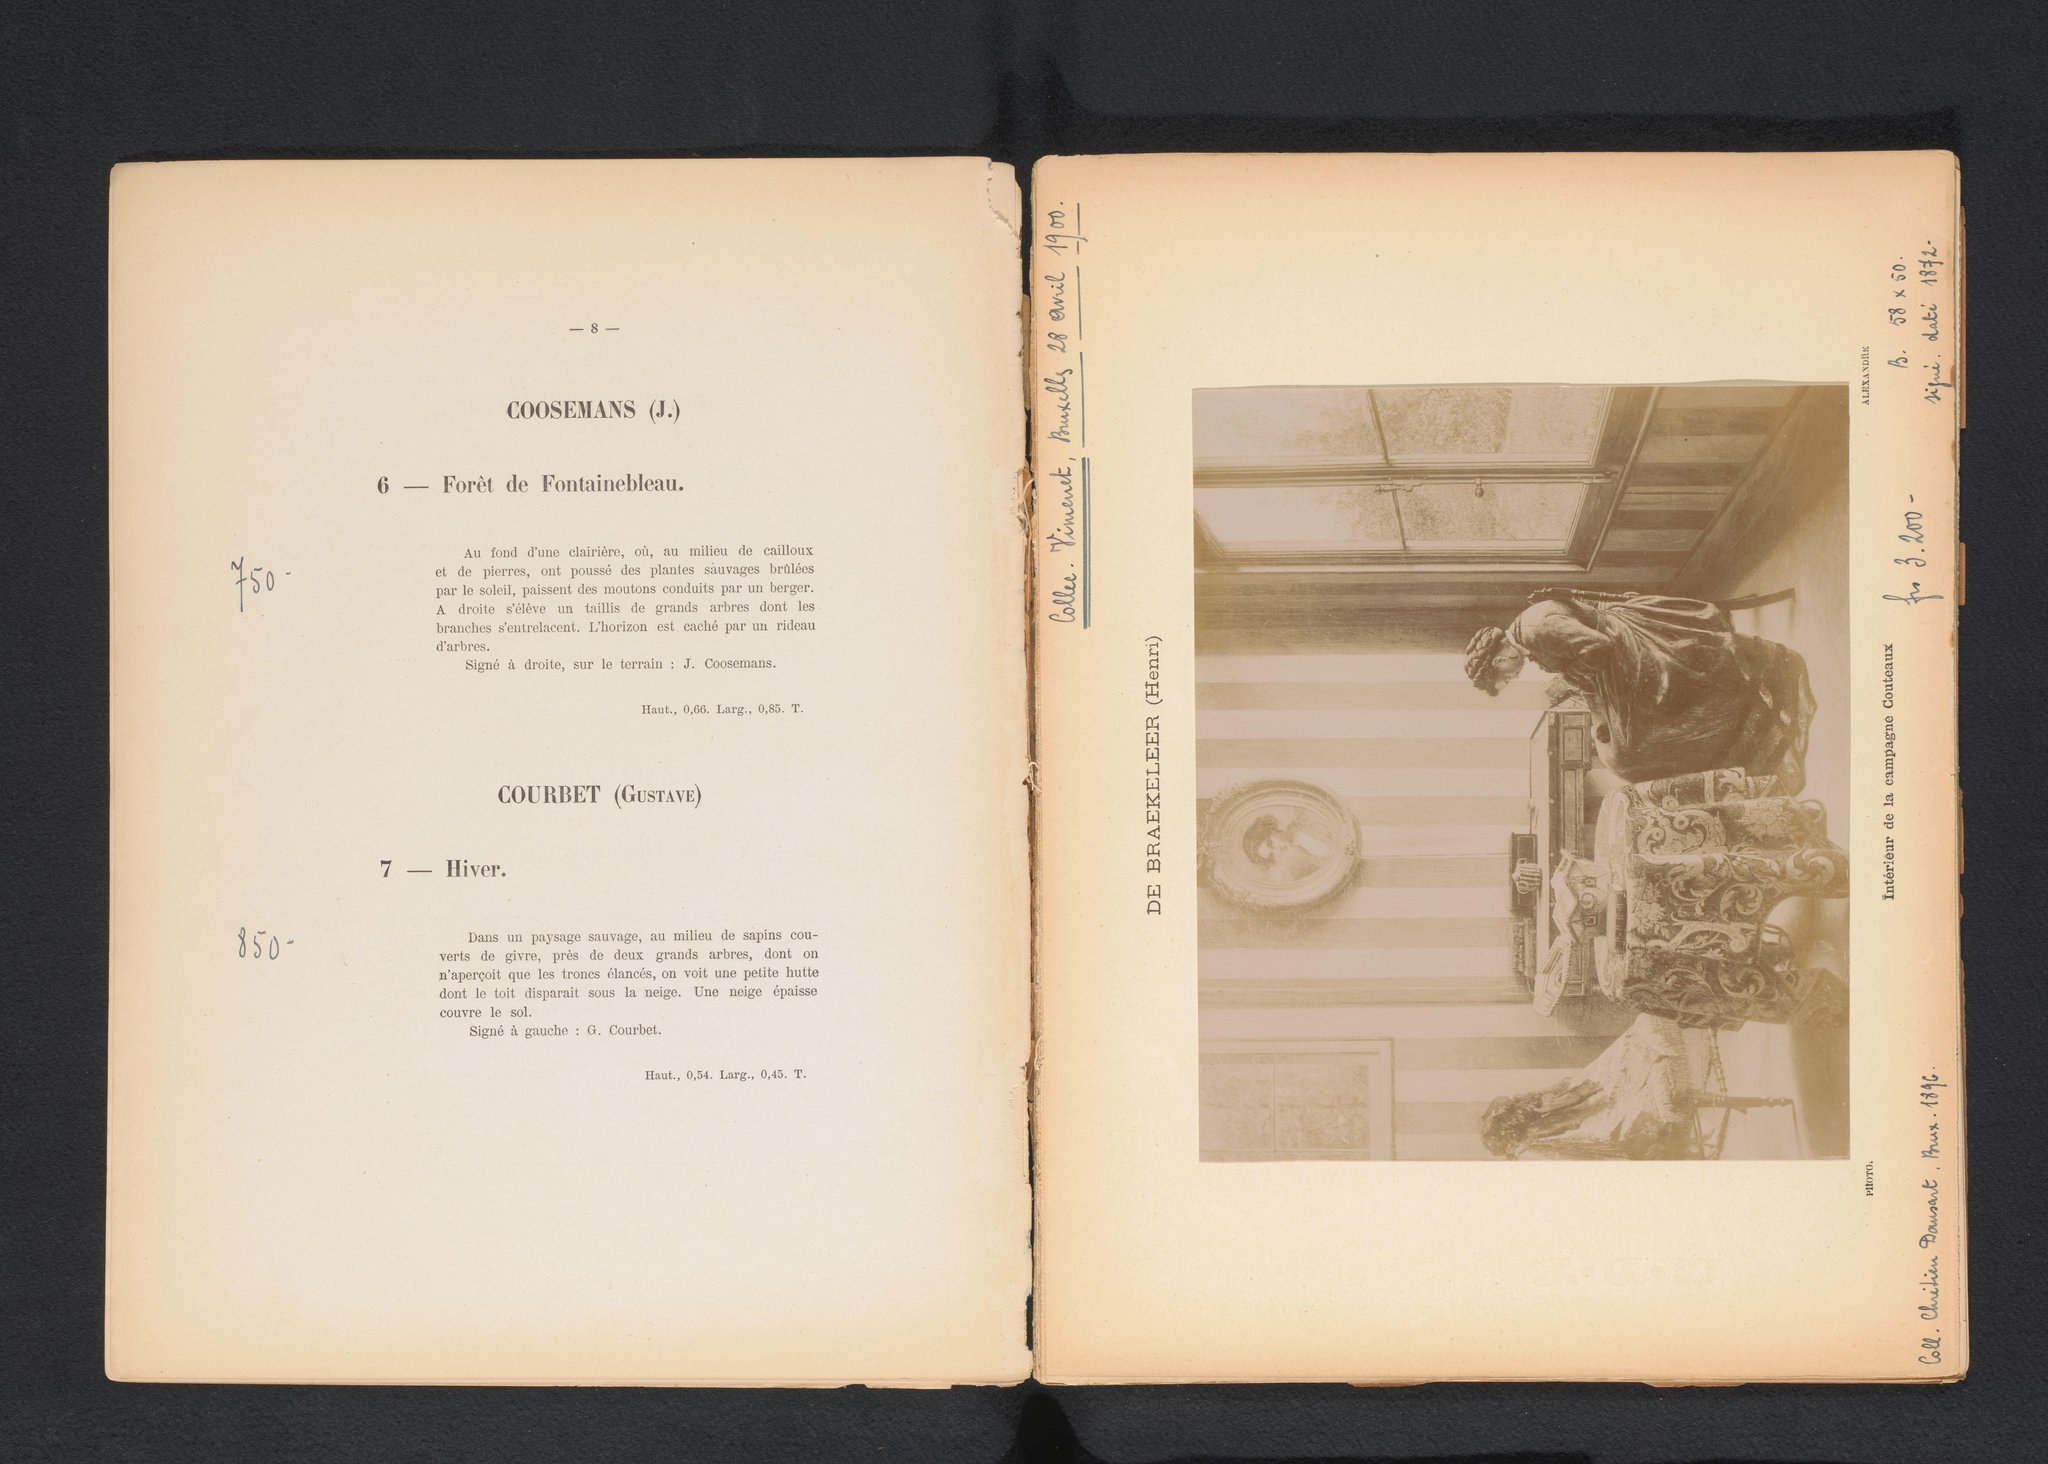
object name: photograph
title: Intérieur de la campagne Couteaux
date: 1895-1900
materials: photographic support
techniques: gelatin silver print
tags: adult woman, (other forms of) needlework, e.g.: crocheting, knitting, embroidering, living-room, parlour, sitting-room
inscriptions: annotation: ‘Coll. Vimenet, Bruxelles 28 Avril 1900.’, annotation: ‘Coll. Chretien Dousant, brux. 1896.’, annotation: ‘B. 58 x 50./ signé. daté 1872.’, number: ‘frs. 3.200-’